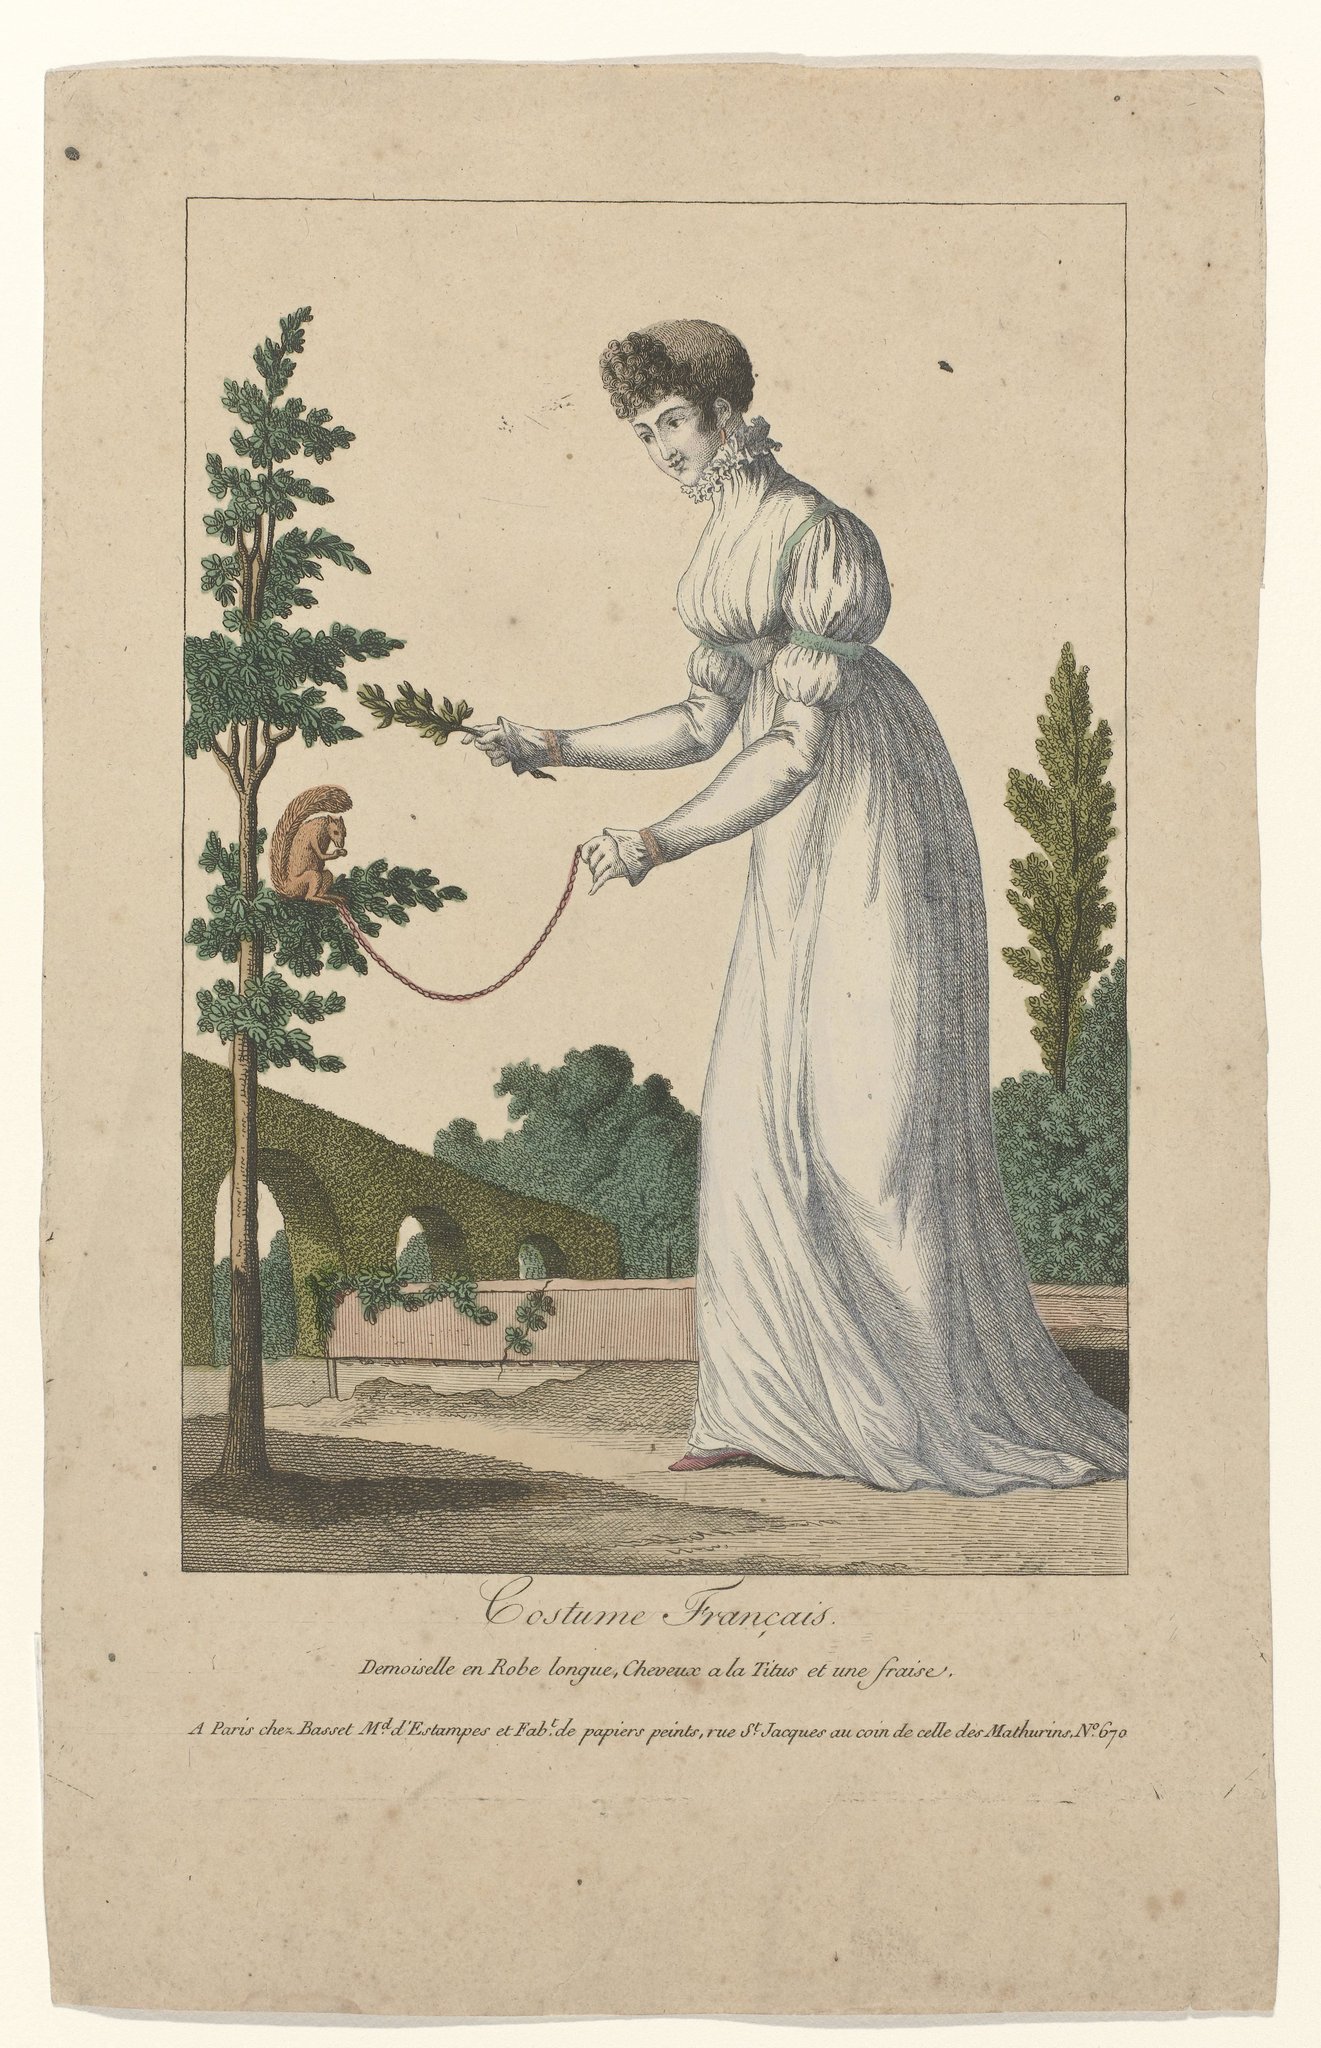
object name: fashion print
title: Costume Français, 1795, No.19 : Demoiselle en Robe longu (...)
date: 1795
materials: paper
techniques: engraving, hand coloring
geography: paris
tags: ear-rings (+ women's clothes), fashion plates, dress, gown (+ women's clothes), neck-gear ~ clothing (+ women's clothes), rodents: squirrel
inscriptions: title: ‘Costume Français’, address: ‘A Paris chez Basset Md. d'Estampes et Fab.t de papier peints, rue St. Jacques au coin de celle des Mathurins, No.670’, caption: ‘Demoiselle en Robe longue, Cheveux a la Titus et une fraise.’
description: Staande ongetrouwde vrouw met een eekhoorn aan een lijn. Zij draagt een japon met een geplooide halskraag (fraise), lange mouwen en sleepje. Het haar is 'a la Titus'. Accessoires: oorbel in het linkeroor, schoen met puntige neus. De prent maakt deel uit van een reeks van ten minste 20 kostuumprenten, uitgegeven door Basset, Parijs, zonder datum (ca. 1795).